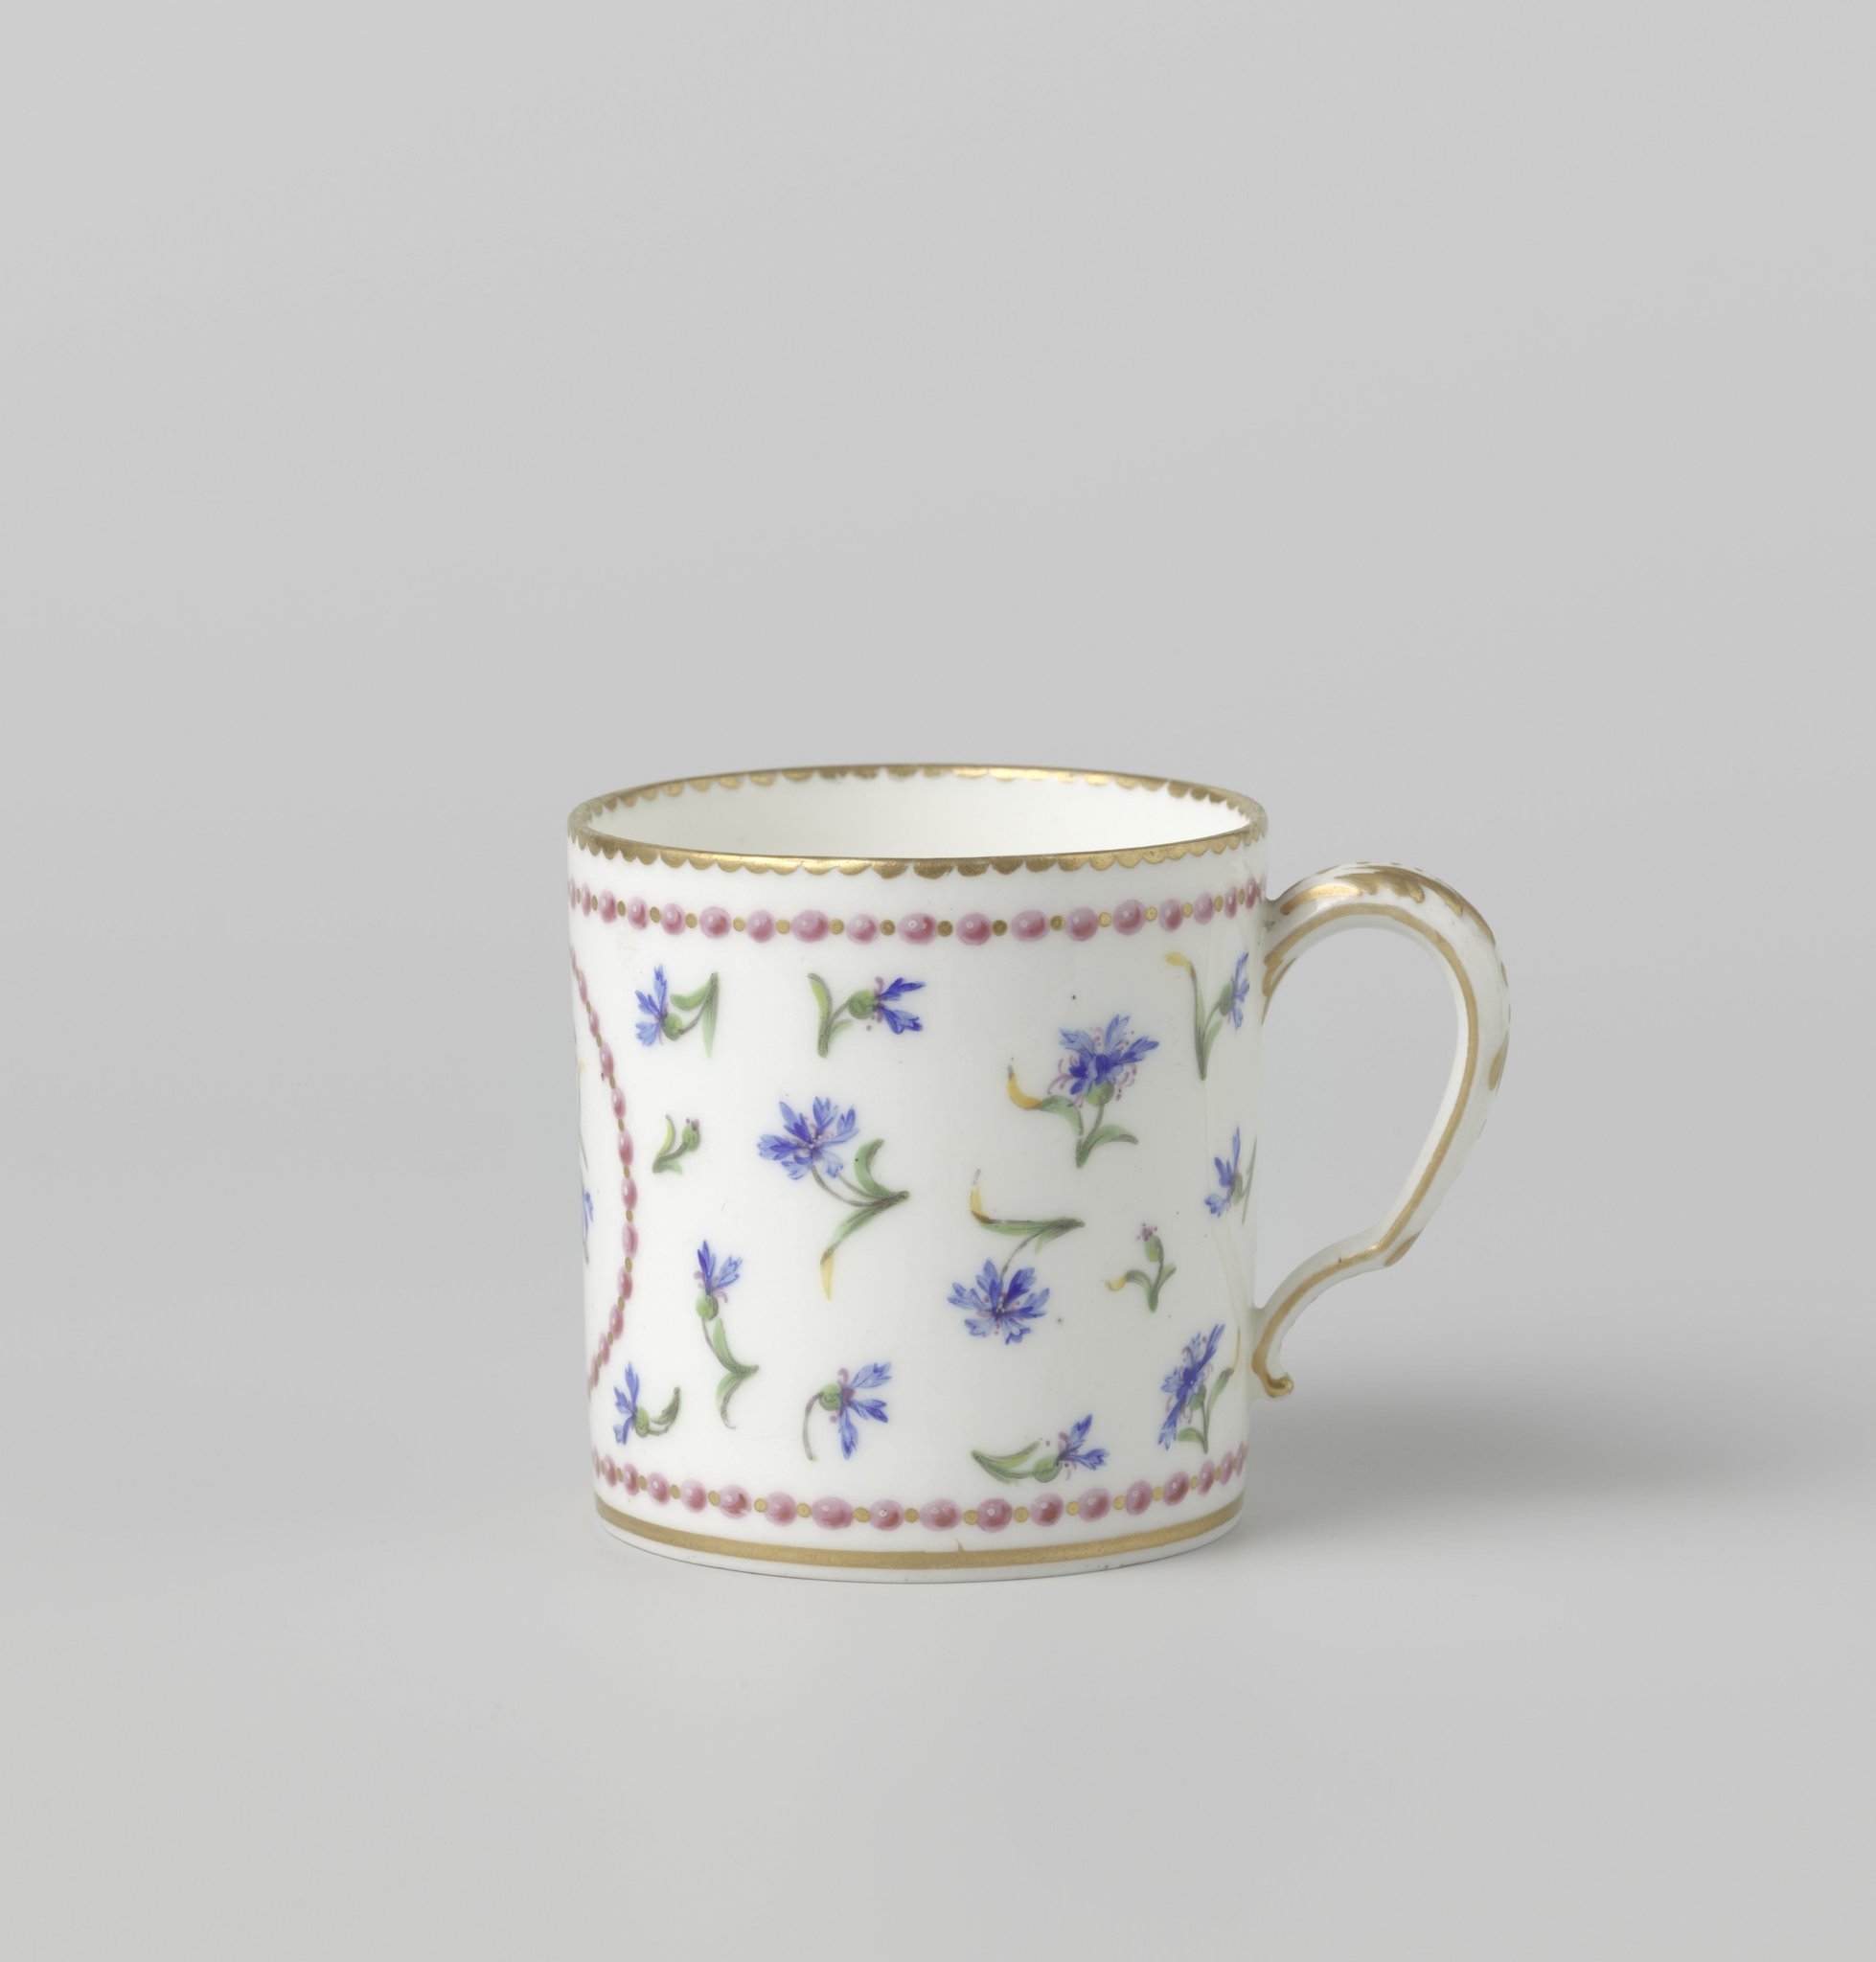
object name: cup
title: Cup with a flower spray in a medallion and flowers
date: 1790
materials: glaze, gold, paint, porcelain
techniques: firing, forming, gilding, turning, vitrification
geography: sèvres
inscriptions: mark: ‘dubbele L/ MM/ wt’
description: Kop van porselein met een cilindrische wand en C-vormig oor, beschilderd op het glazuur in blauw. De buitenwand is bedekt met strooibloemen, aan de voorzijde onderbroken door een medaillon van roze en gouden parels met daarin een bloemtak. Hierboven en -onder eenzelfde band met roze parels. Boven de voet een gouden lijnen en op de binnen- en buitenrand een band met halve gouden bollen. Op het oor een palmet en stippen. Gemerkt op de onderzijde met de dubbele L, jaarletters MM en wt.